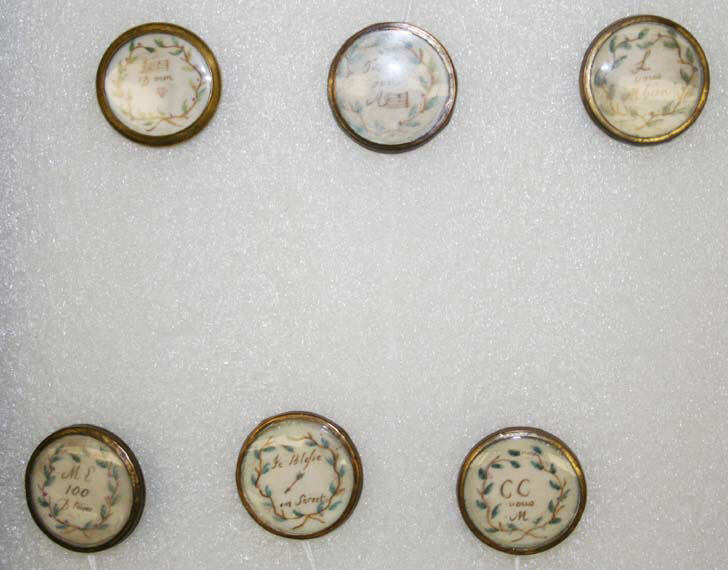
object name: button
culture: french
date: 1775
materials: glass, ivory